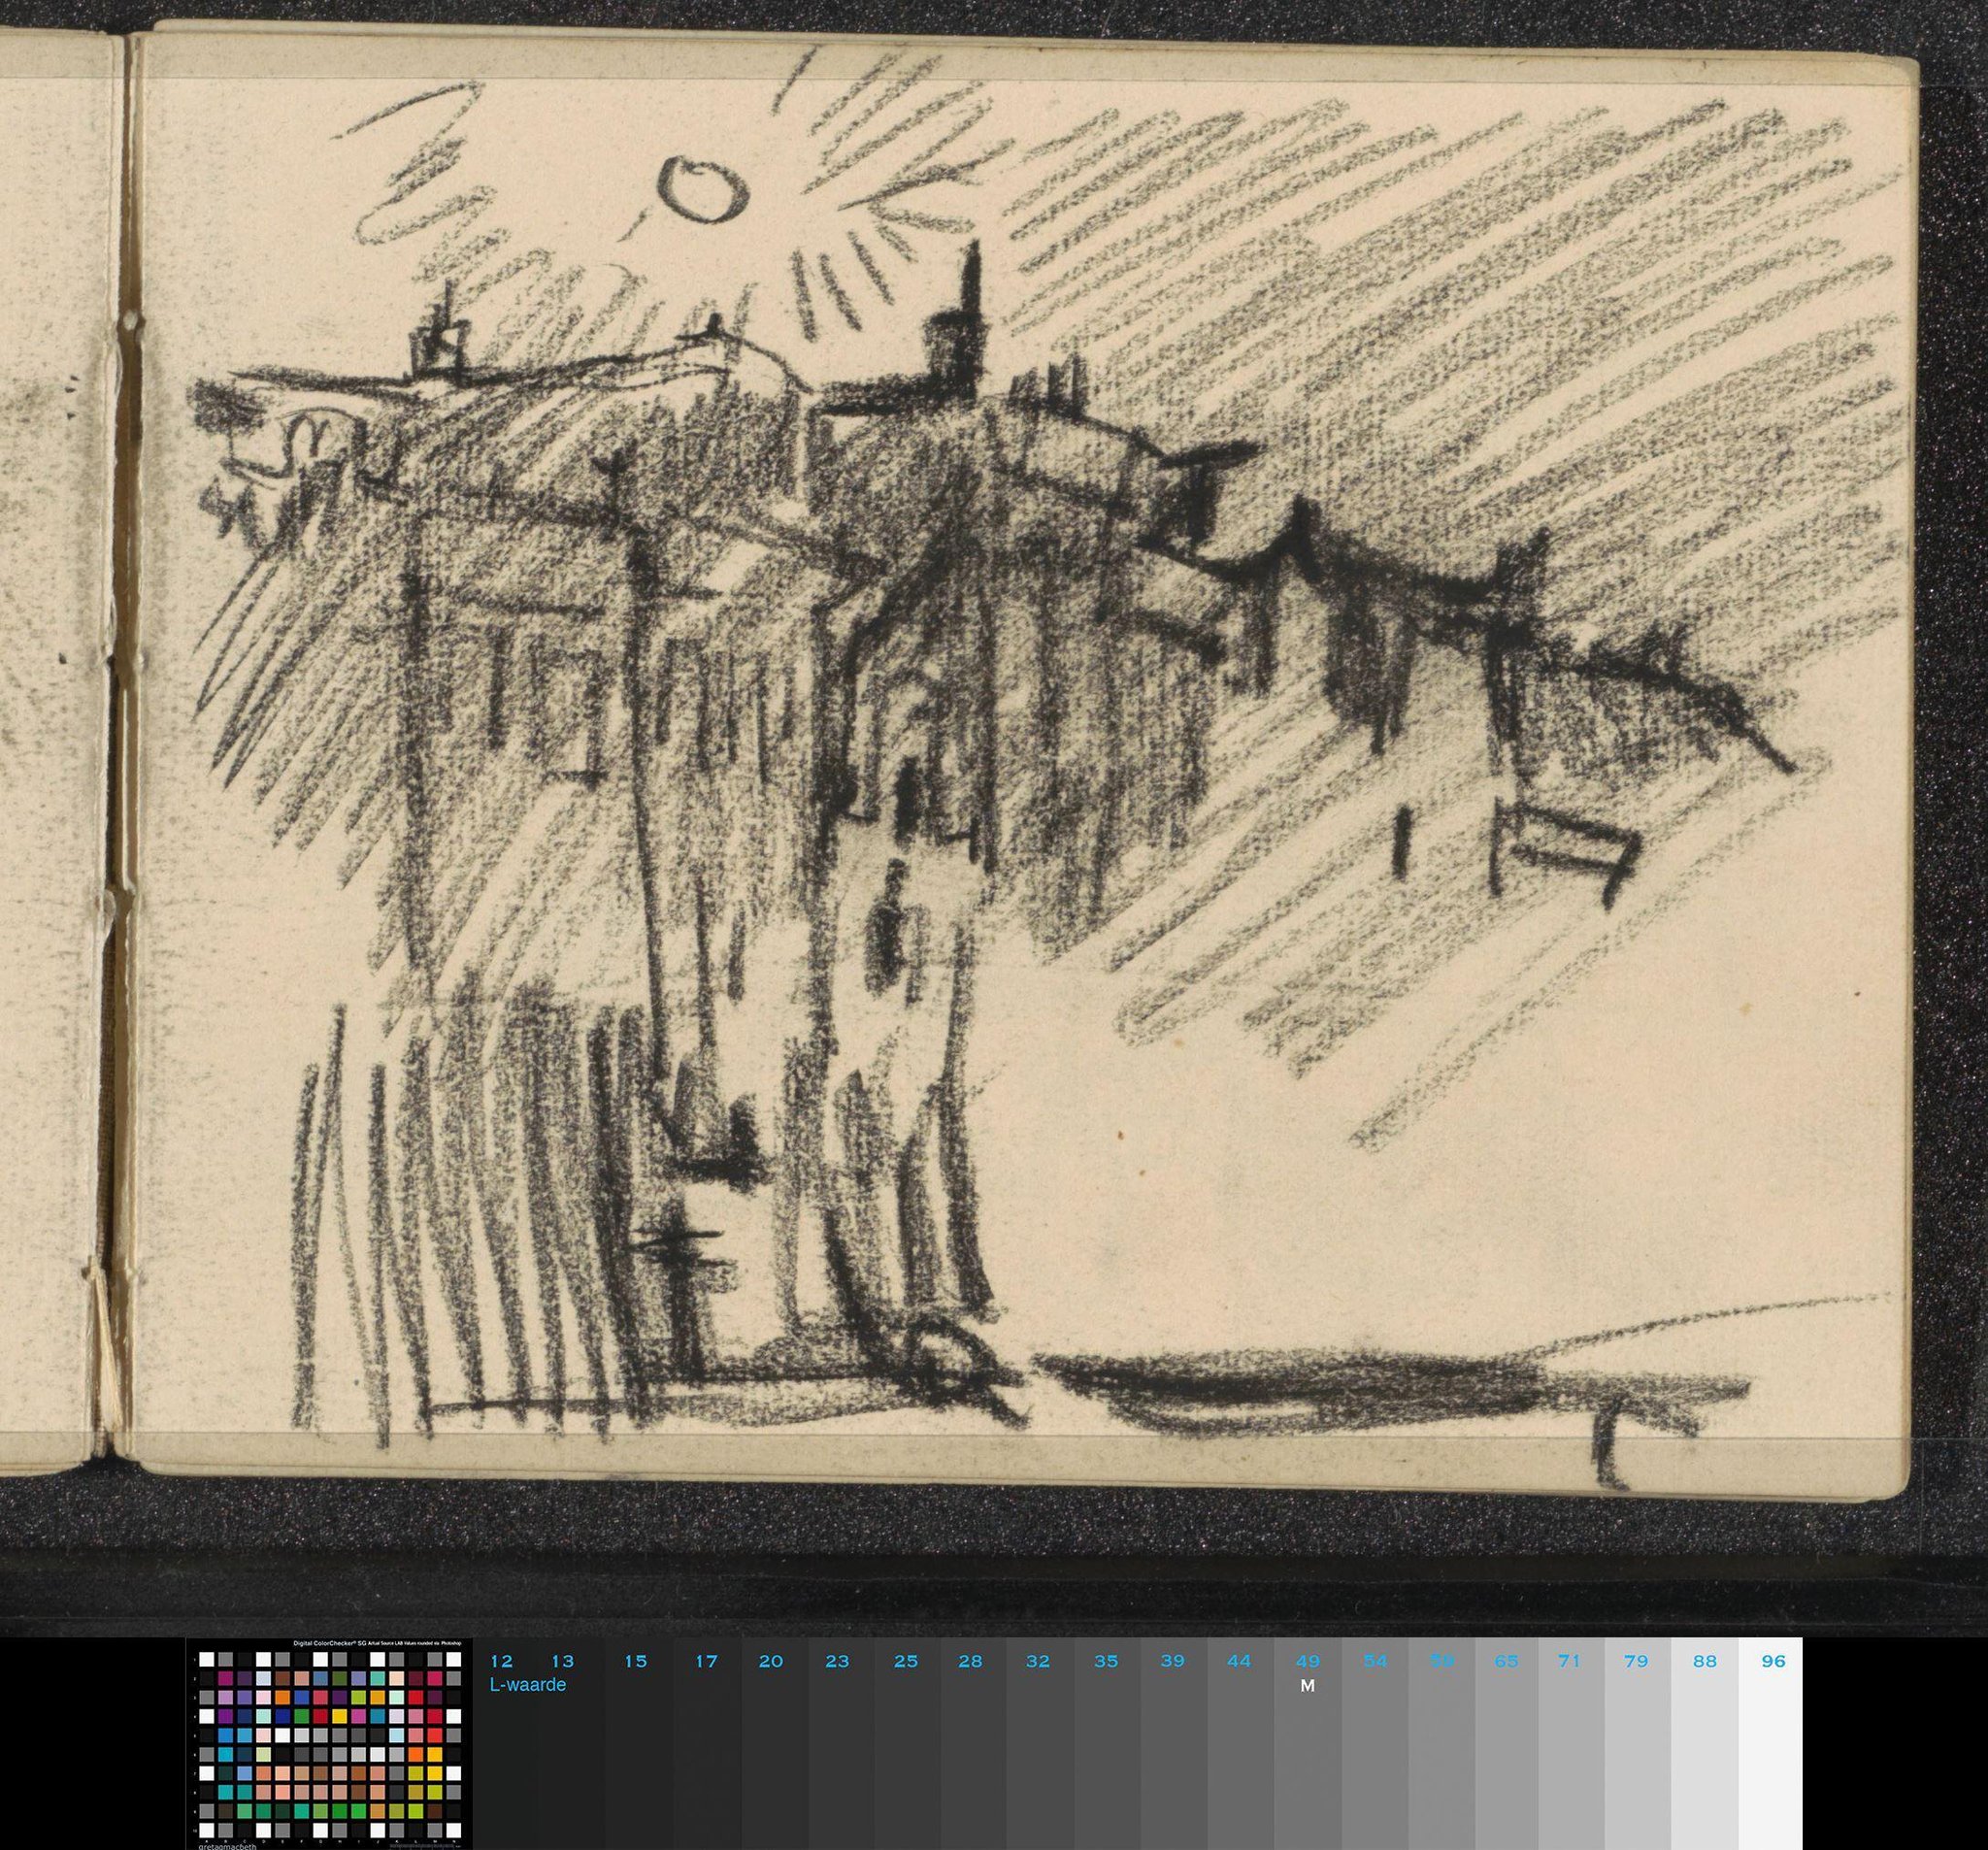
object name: sketchbook leaf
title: Gezicht in Amsterdam, mogelijk de Dam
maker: george hendrik breitner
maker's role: draughtsman, painter, print maker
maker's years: 1857-1923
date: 1893-1912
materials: chalk, paper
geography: amsterdam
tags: civic architecture; edifices; dwellings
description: Pagina 28 uit een schetsboek met 32 bladen.